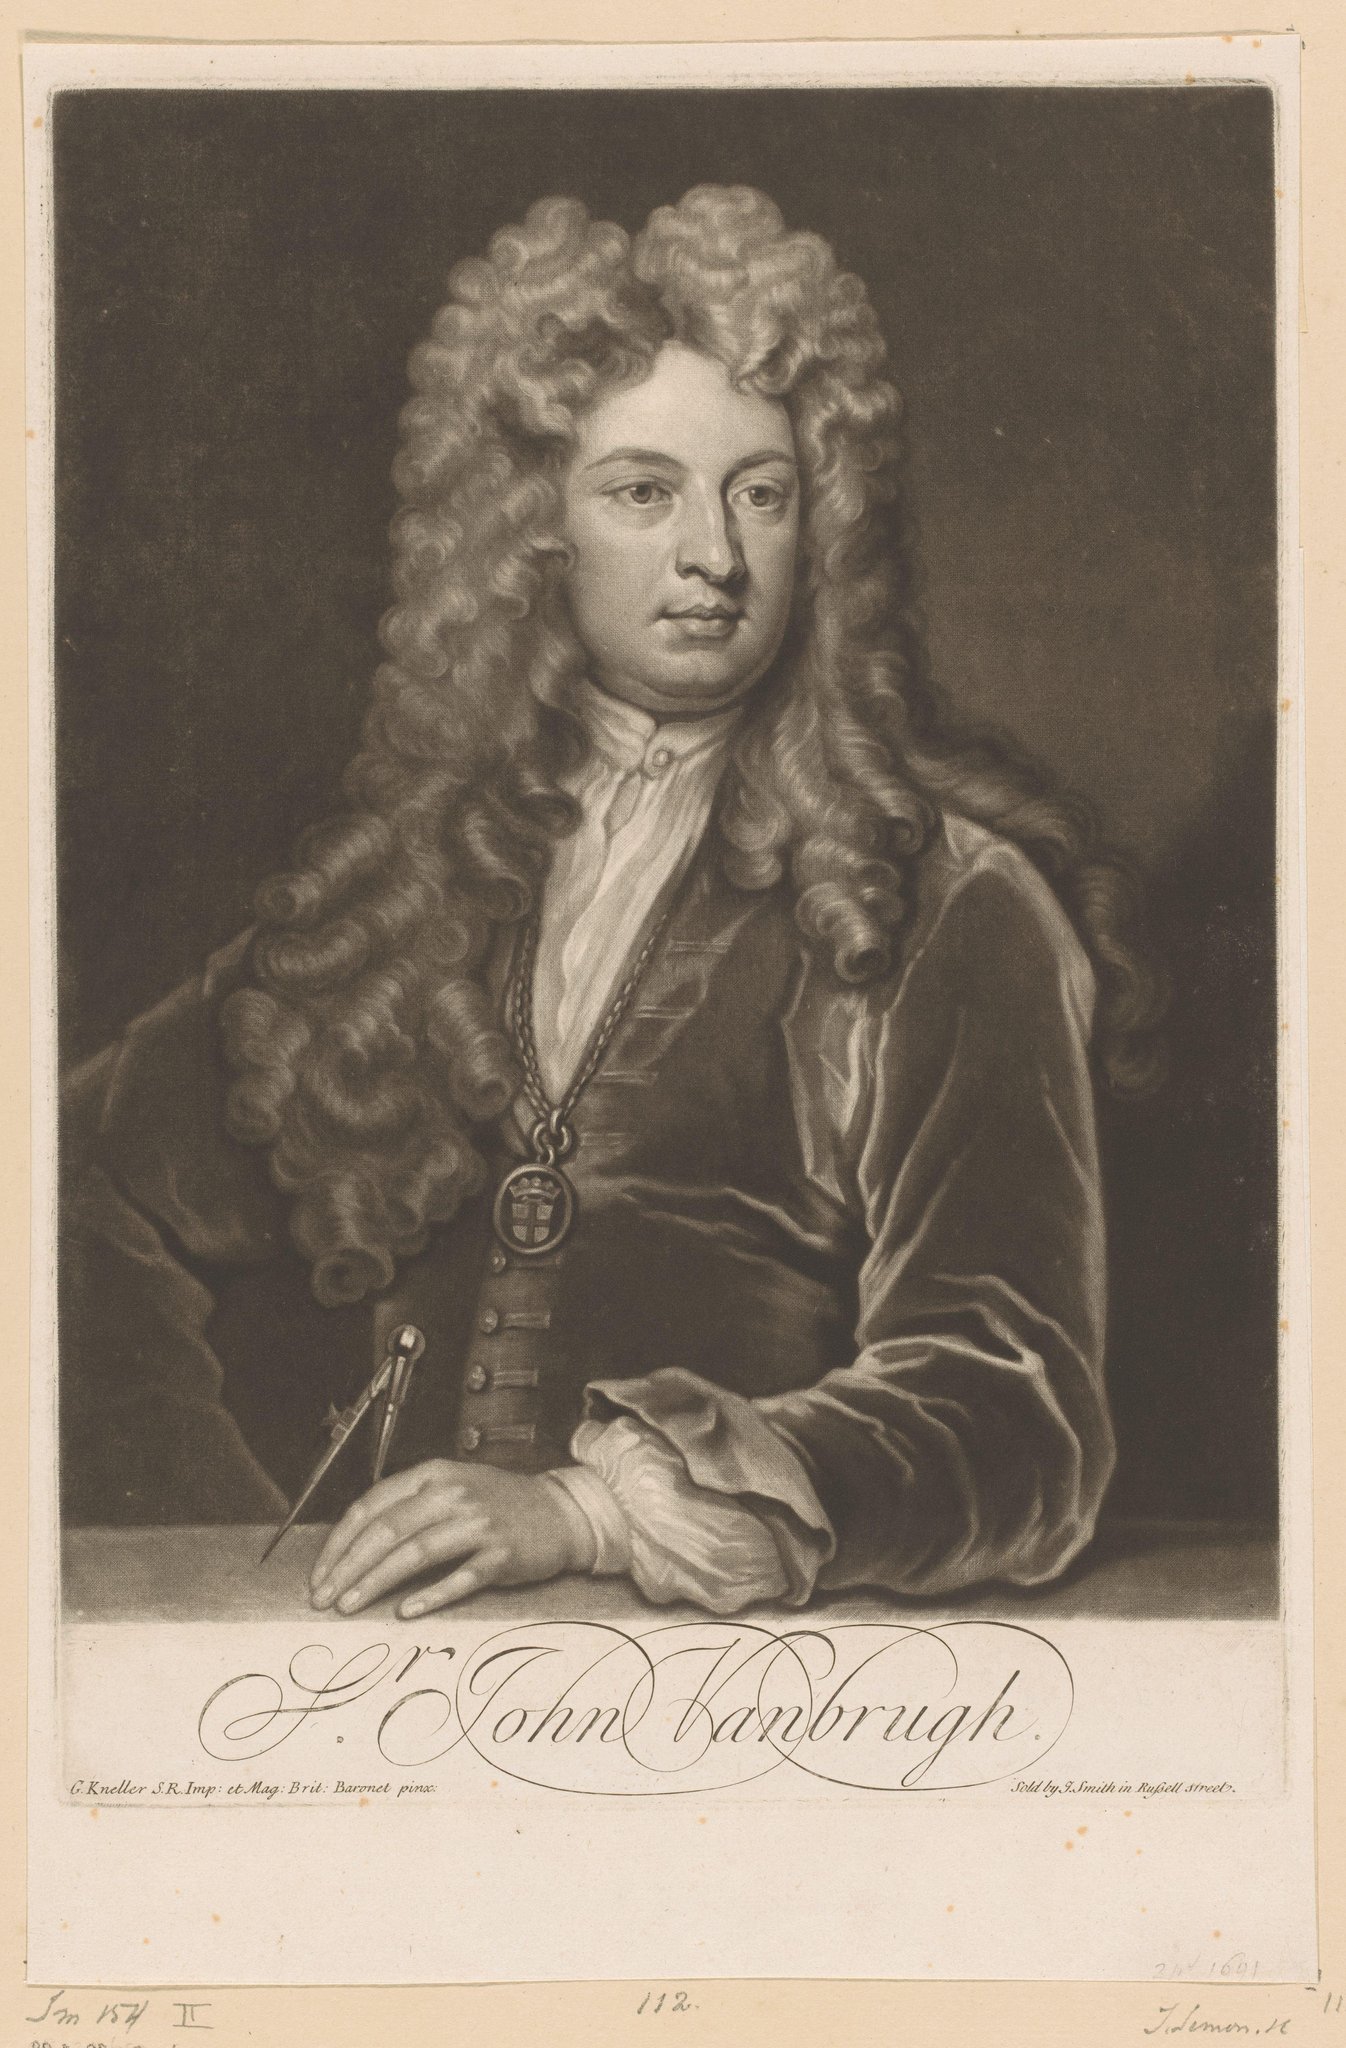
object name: print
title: Portret van John Vanbrugh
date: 1685-1751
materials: paper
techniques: mezzotint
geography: london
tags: historical persons, portrait, self-portrait of architect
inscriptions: collector's mark: Lugt 240